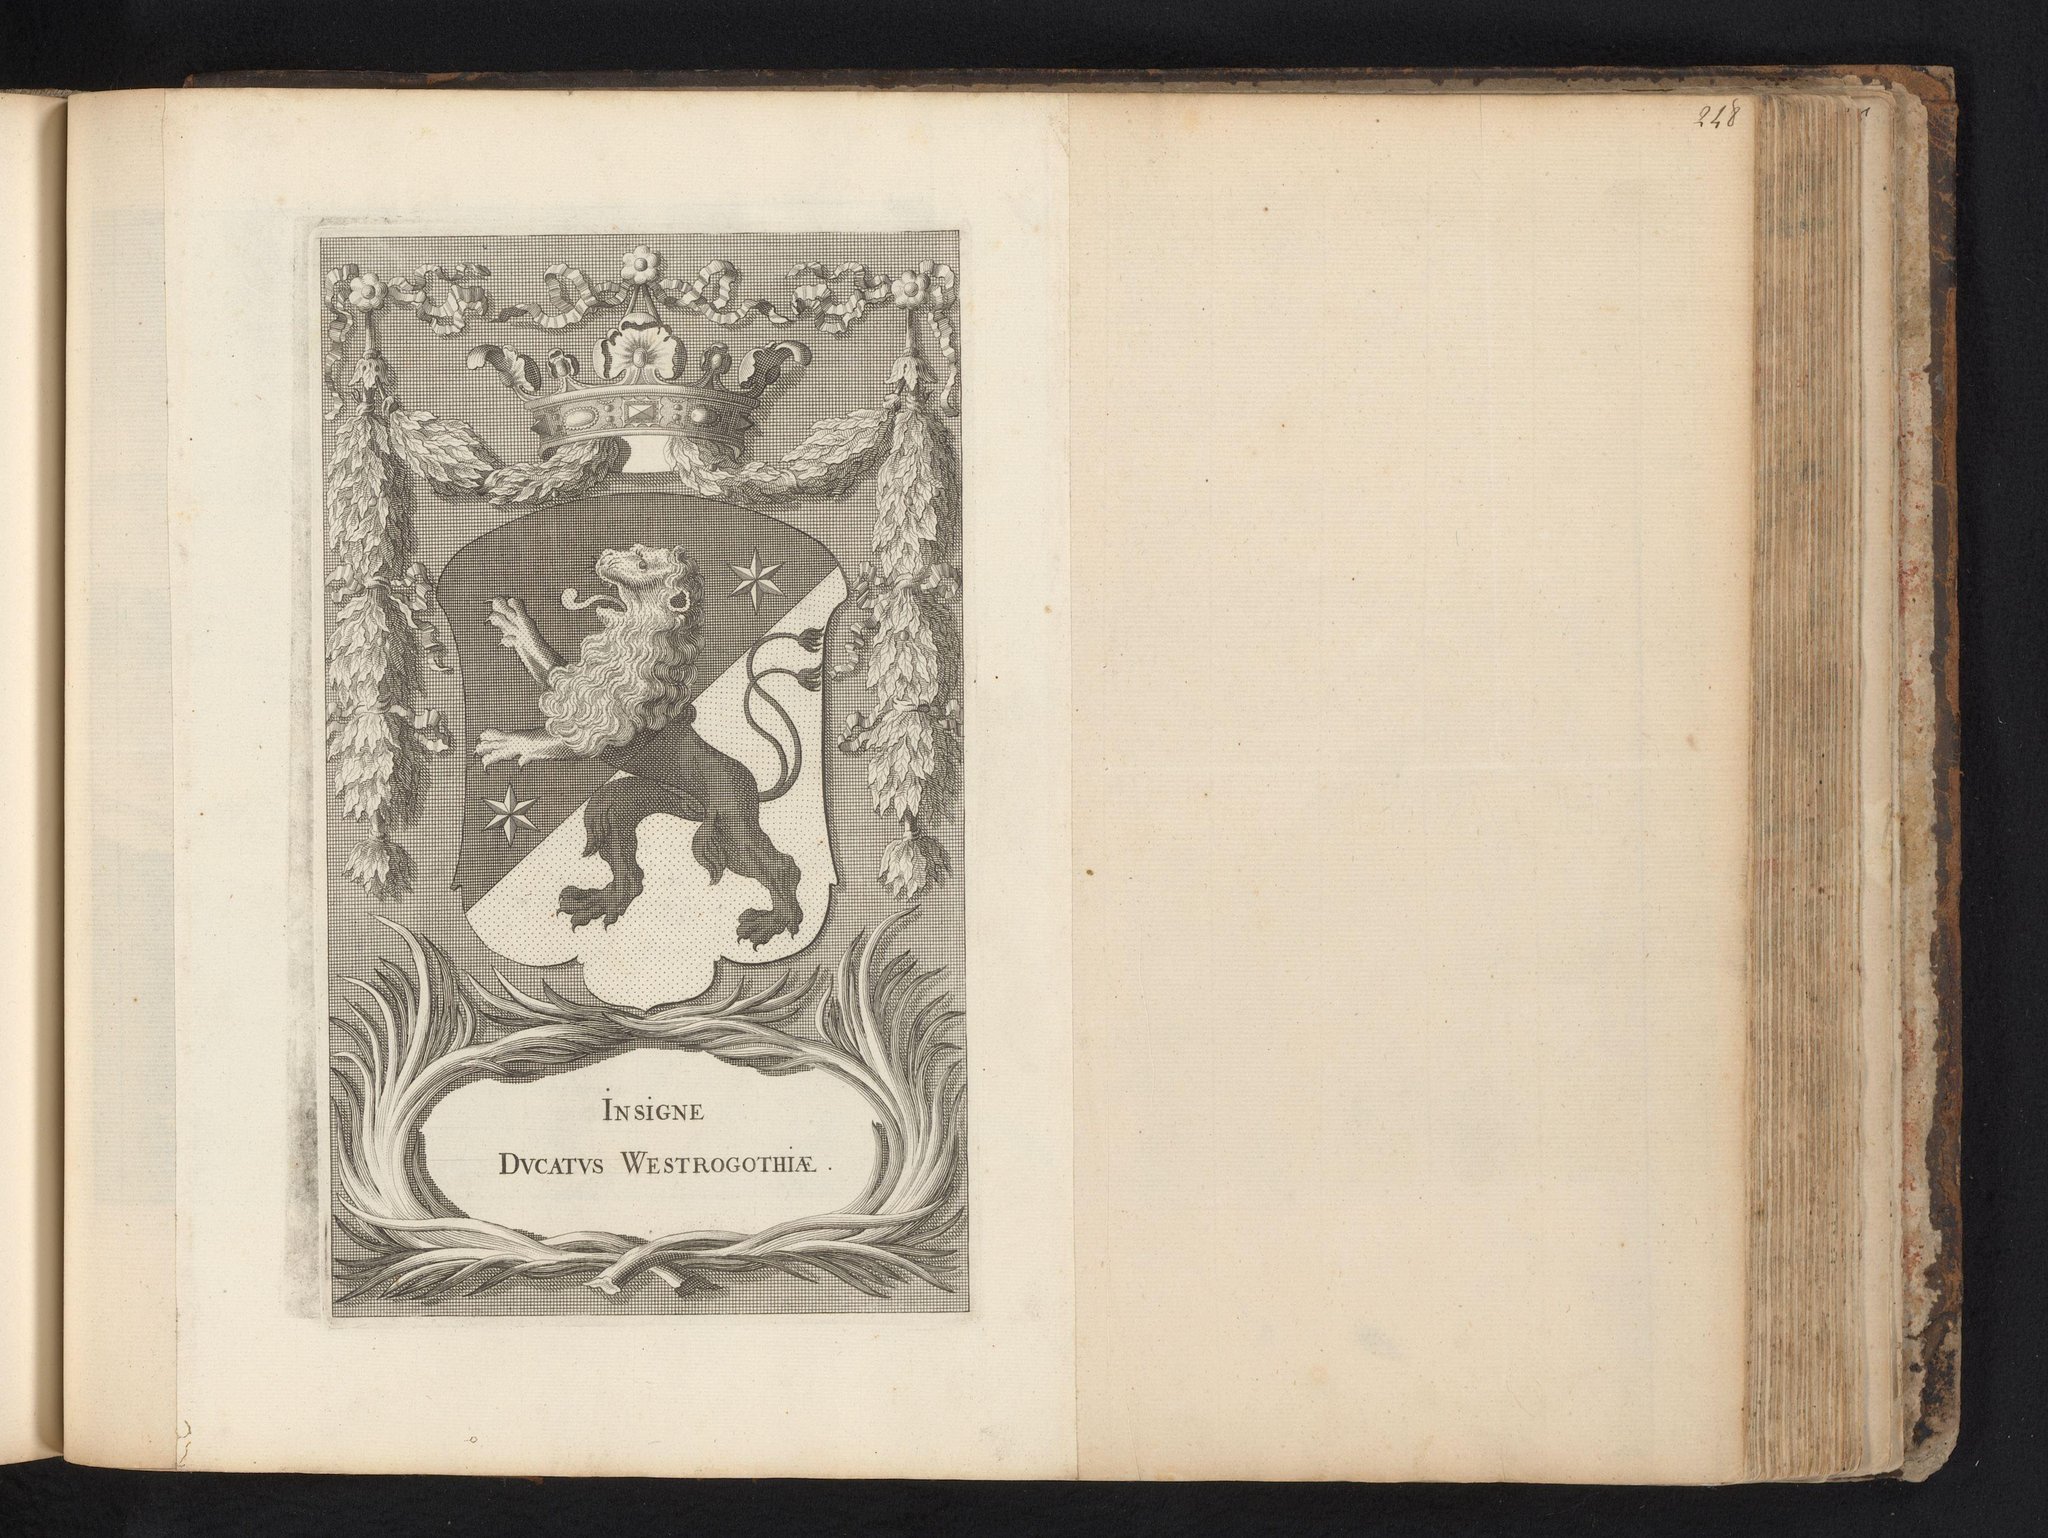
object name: print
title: Wapen van Västergötland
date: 1696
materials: paper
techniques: etching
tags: coat of arms (as symbol of the state, etc.)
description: Kungliga Biblioteket, 'Suecia': http://www.kb.se/samlingarna/Kartor-bilder/Suecia-antiqua/ (geraadpleegd november 2016).